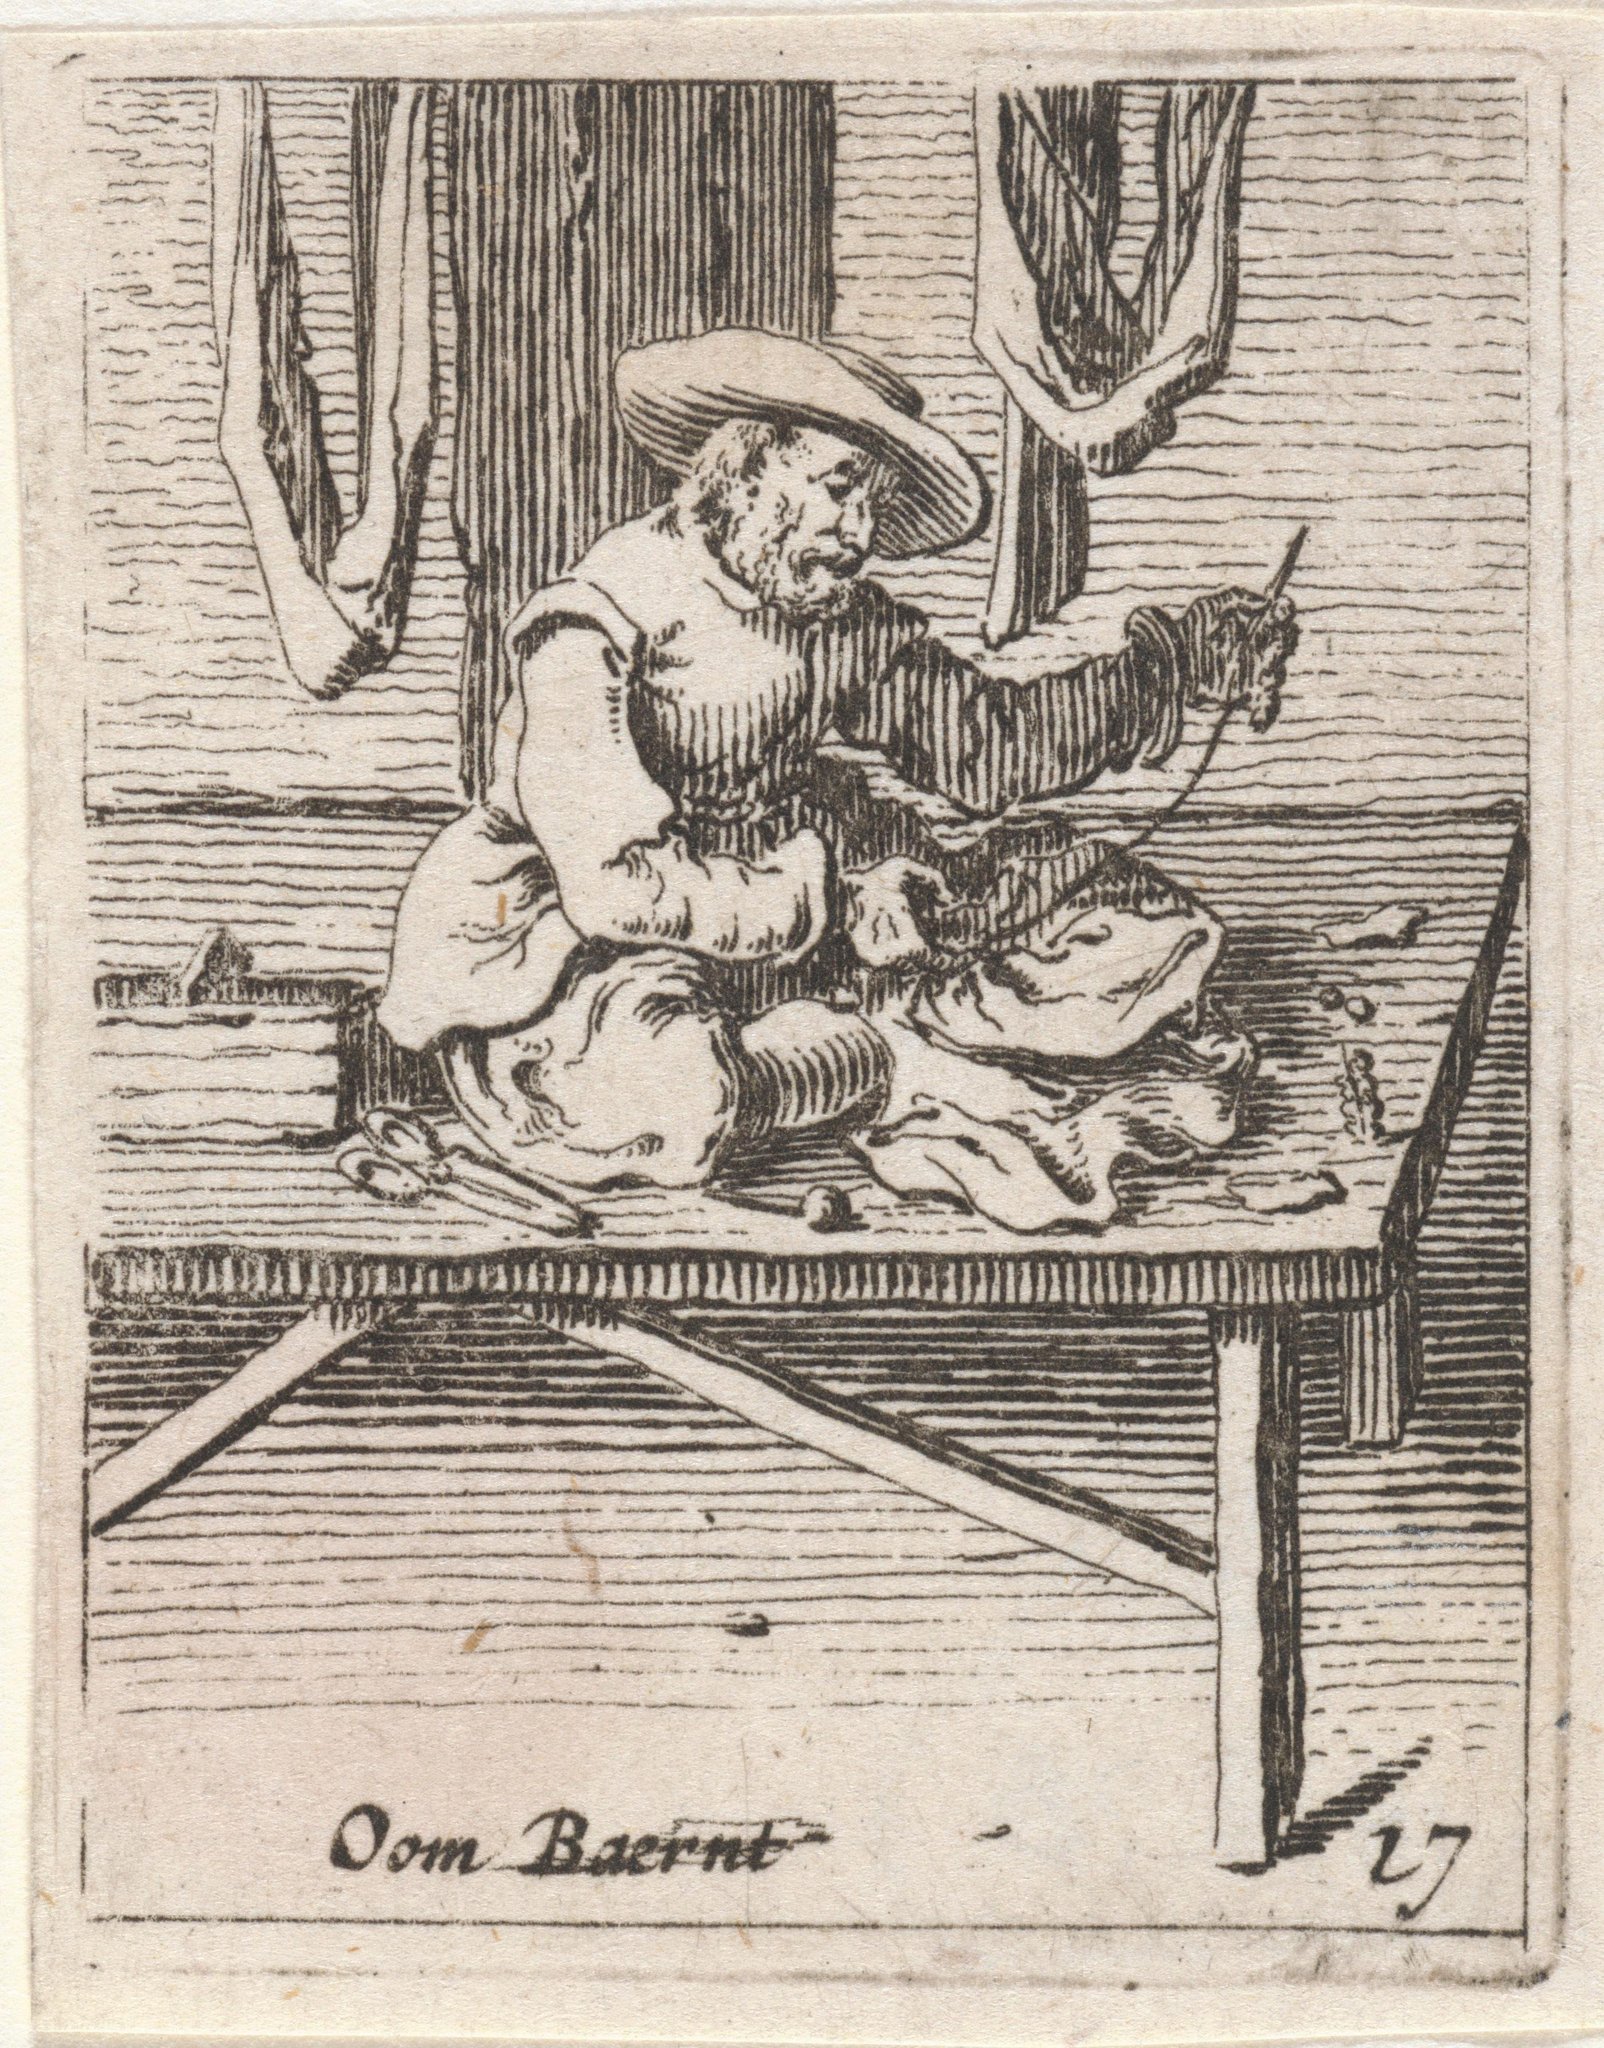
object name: print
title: Kleermaker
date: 1630-1706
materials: paper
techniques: etching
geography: amsterdam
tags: tailor, dressmaker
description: Een kleermaker (Oom Baernt) zit op een tafel kleding te naaien. Achter hem hangen lappen stof. De prent maakt deel uit van een serie van 32 prenten met genretaferelen.